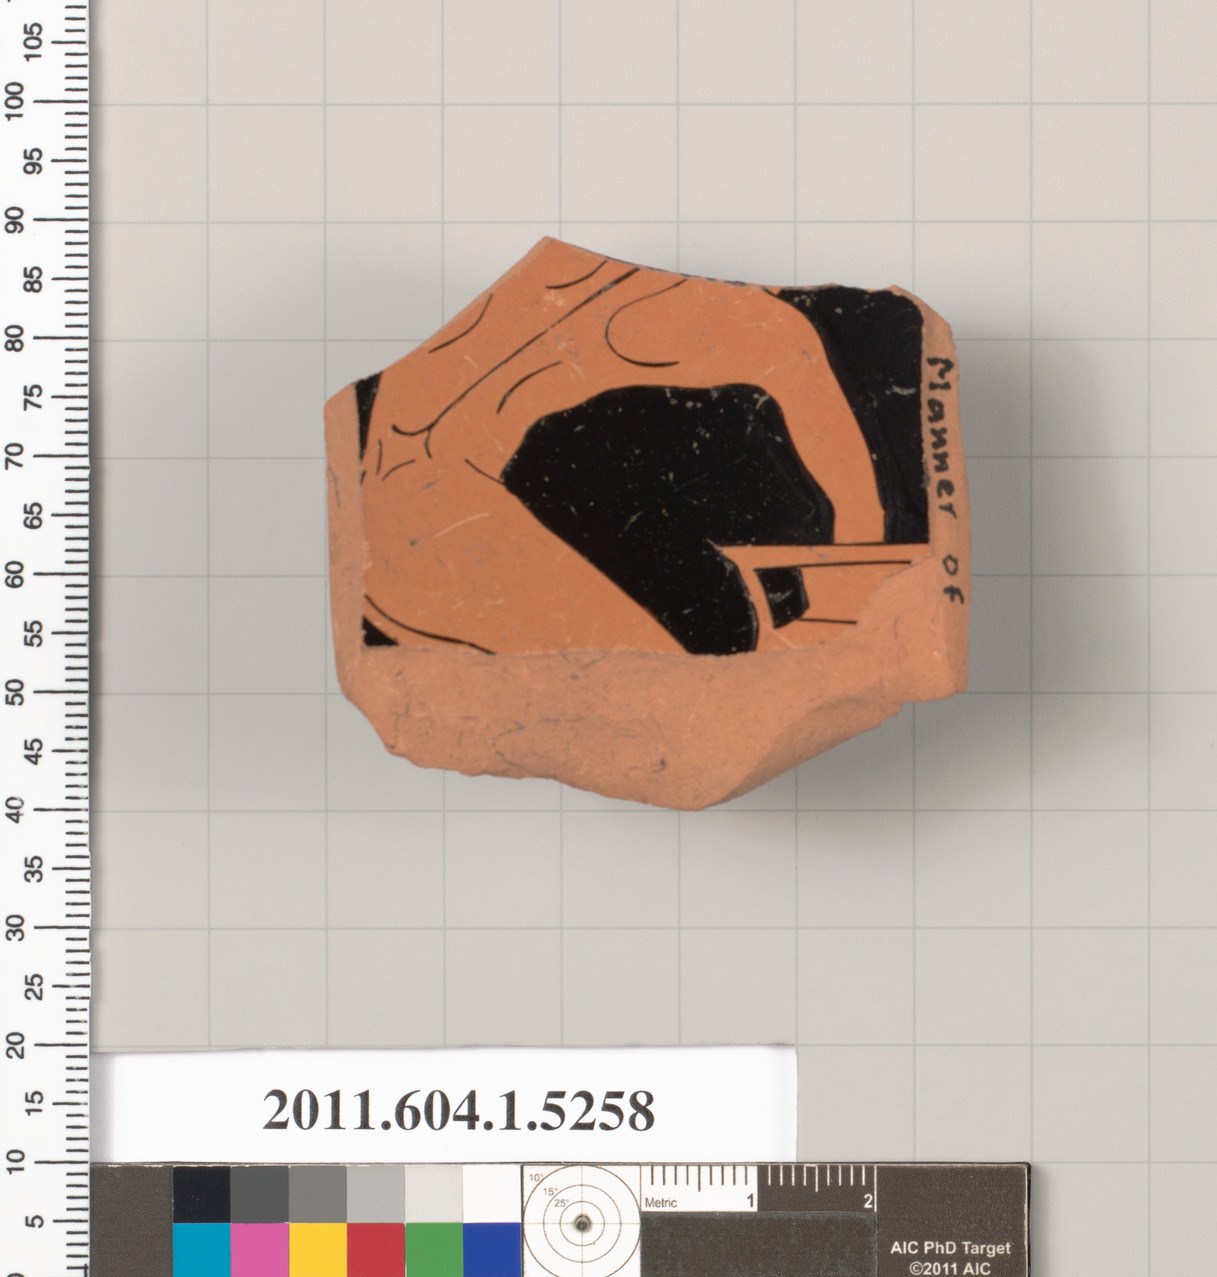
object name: kylix fragment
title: Terracotta fragment of a kylix (drinking cup)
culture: greek, attic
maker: euergides painter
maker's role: artist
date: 510-500 BCE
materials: terracotta